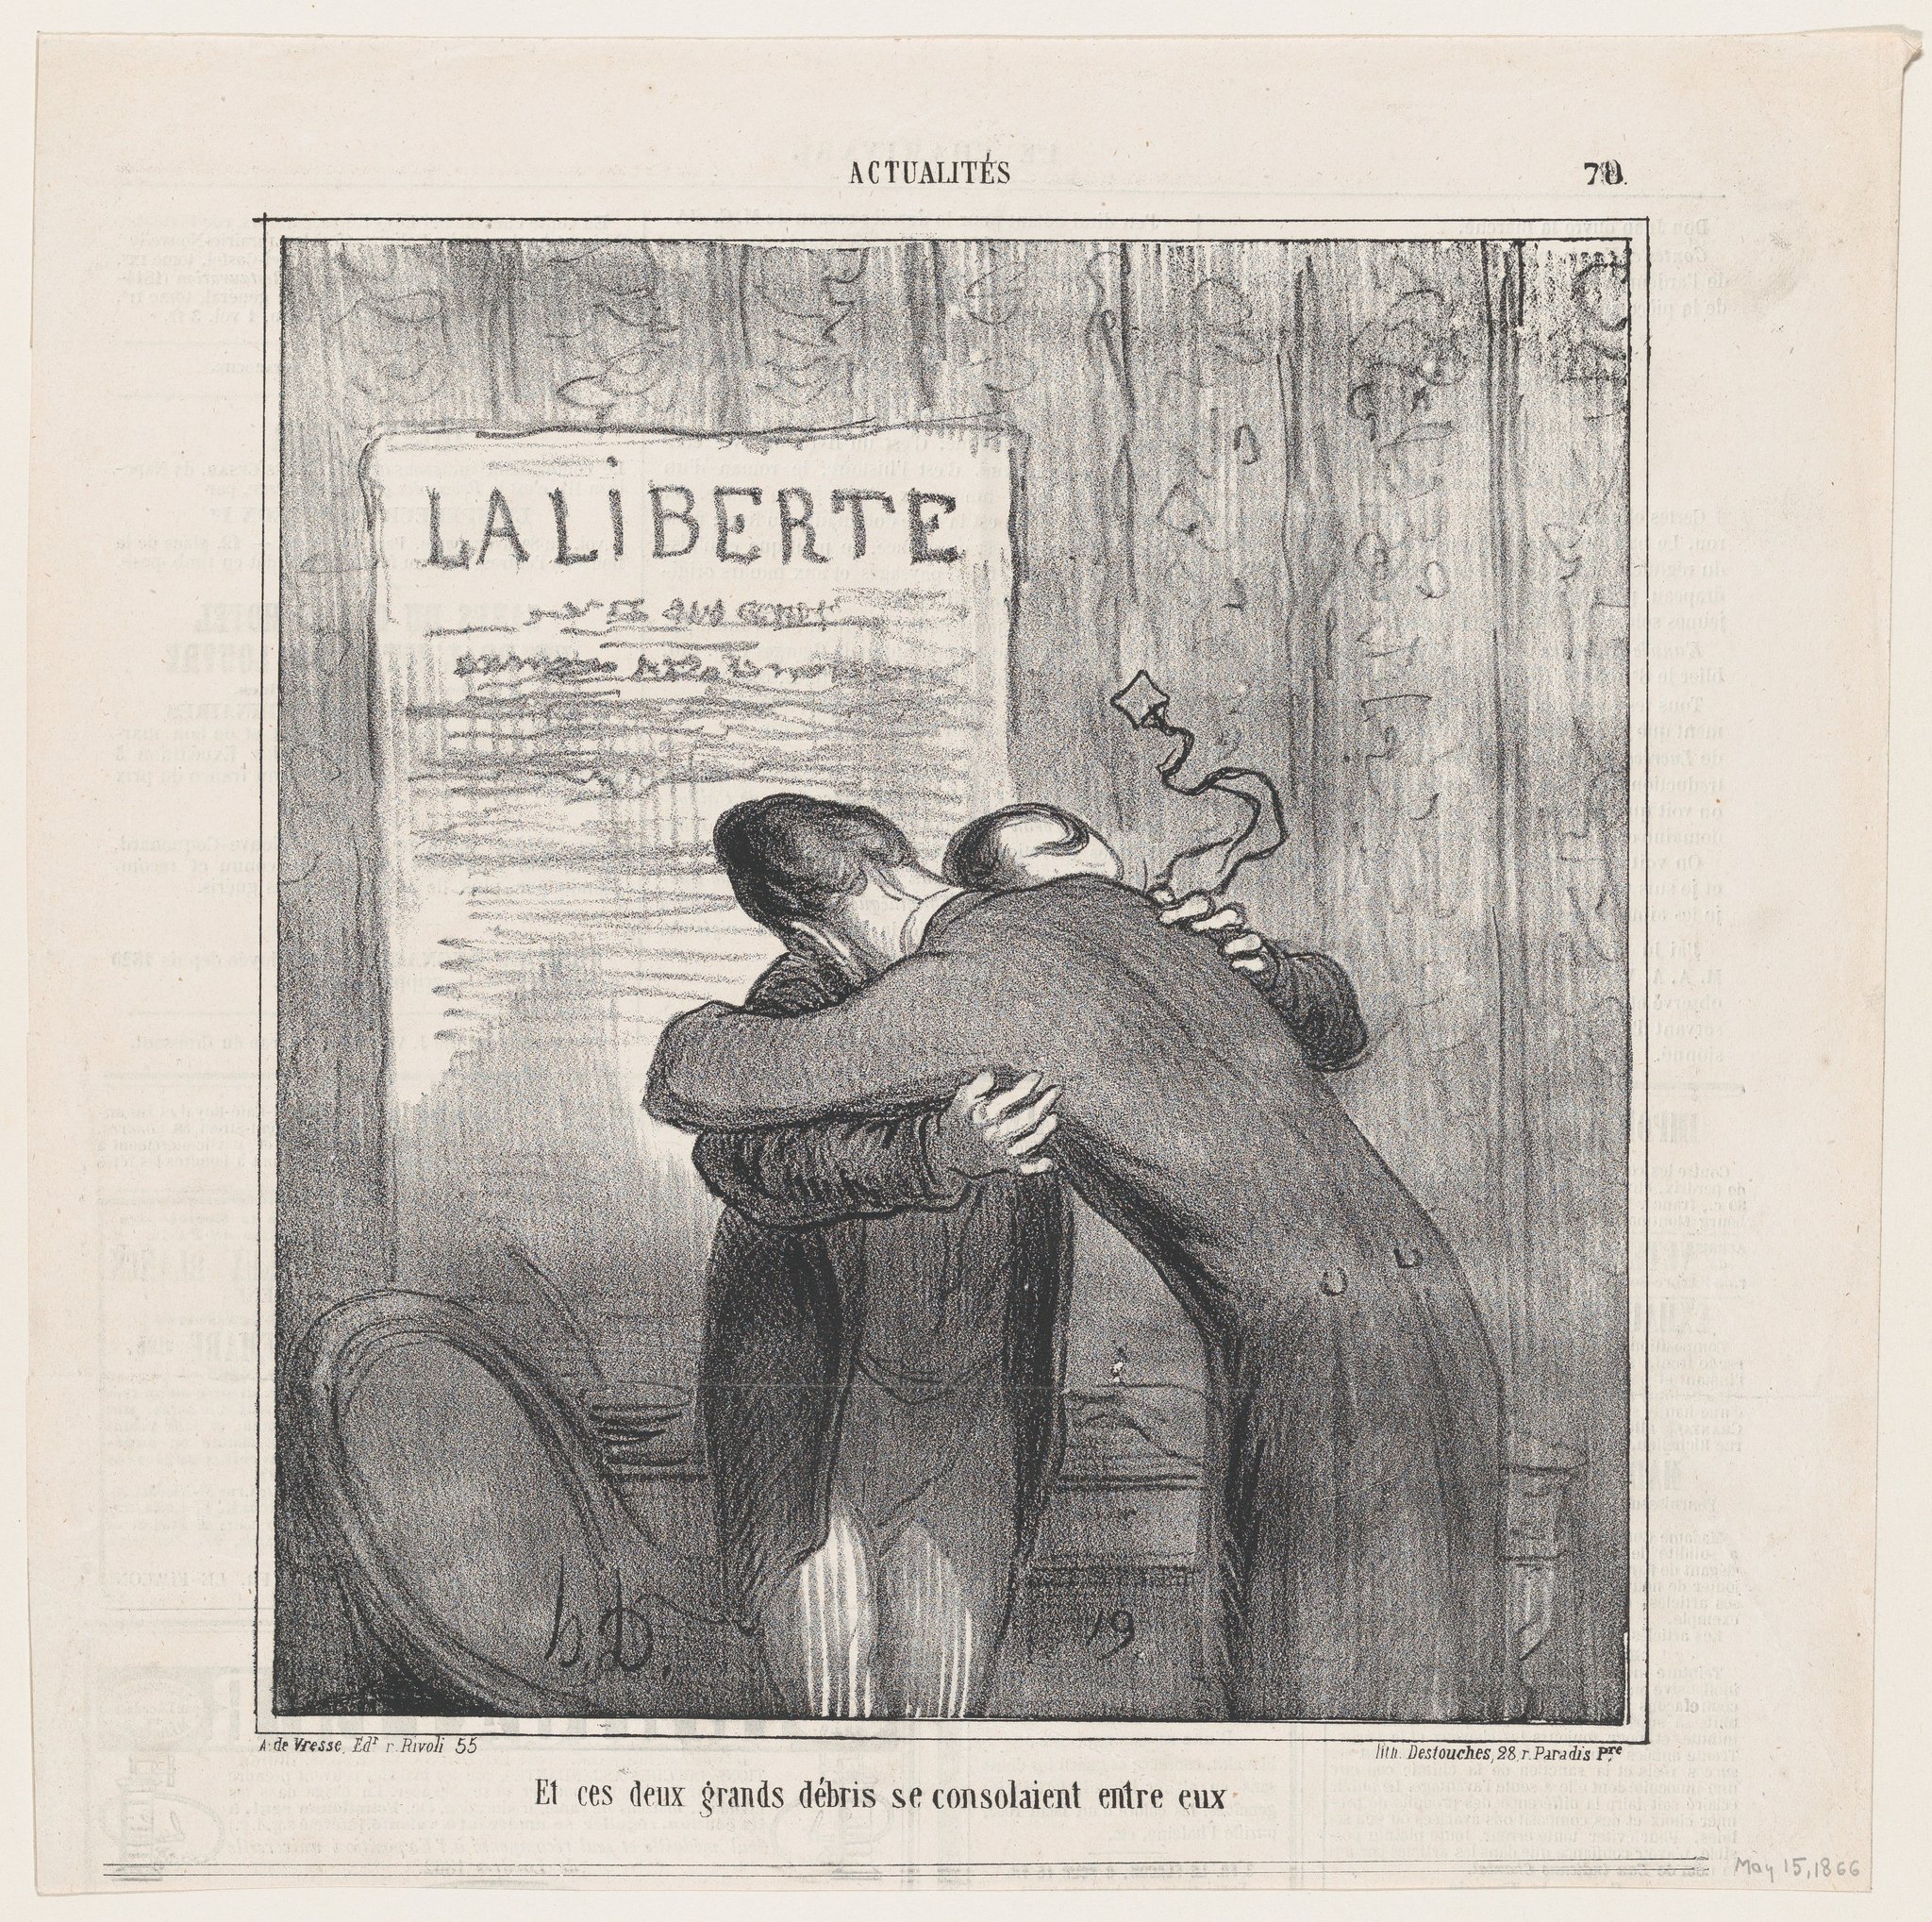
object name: print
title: And these two old wrecks consoled each other, from 'News of the day,' published in Le Charivari, May 15, 1866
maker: honoré daumier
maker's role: artist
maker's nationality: french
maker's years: 1808-1879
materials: paper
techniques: lithograph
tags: men